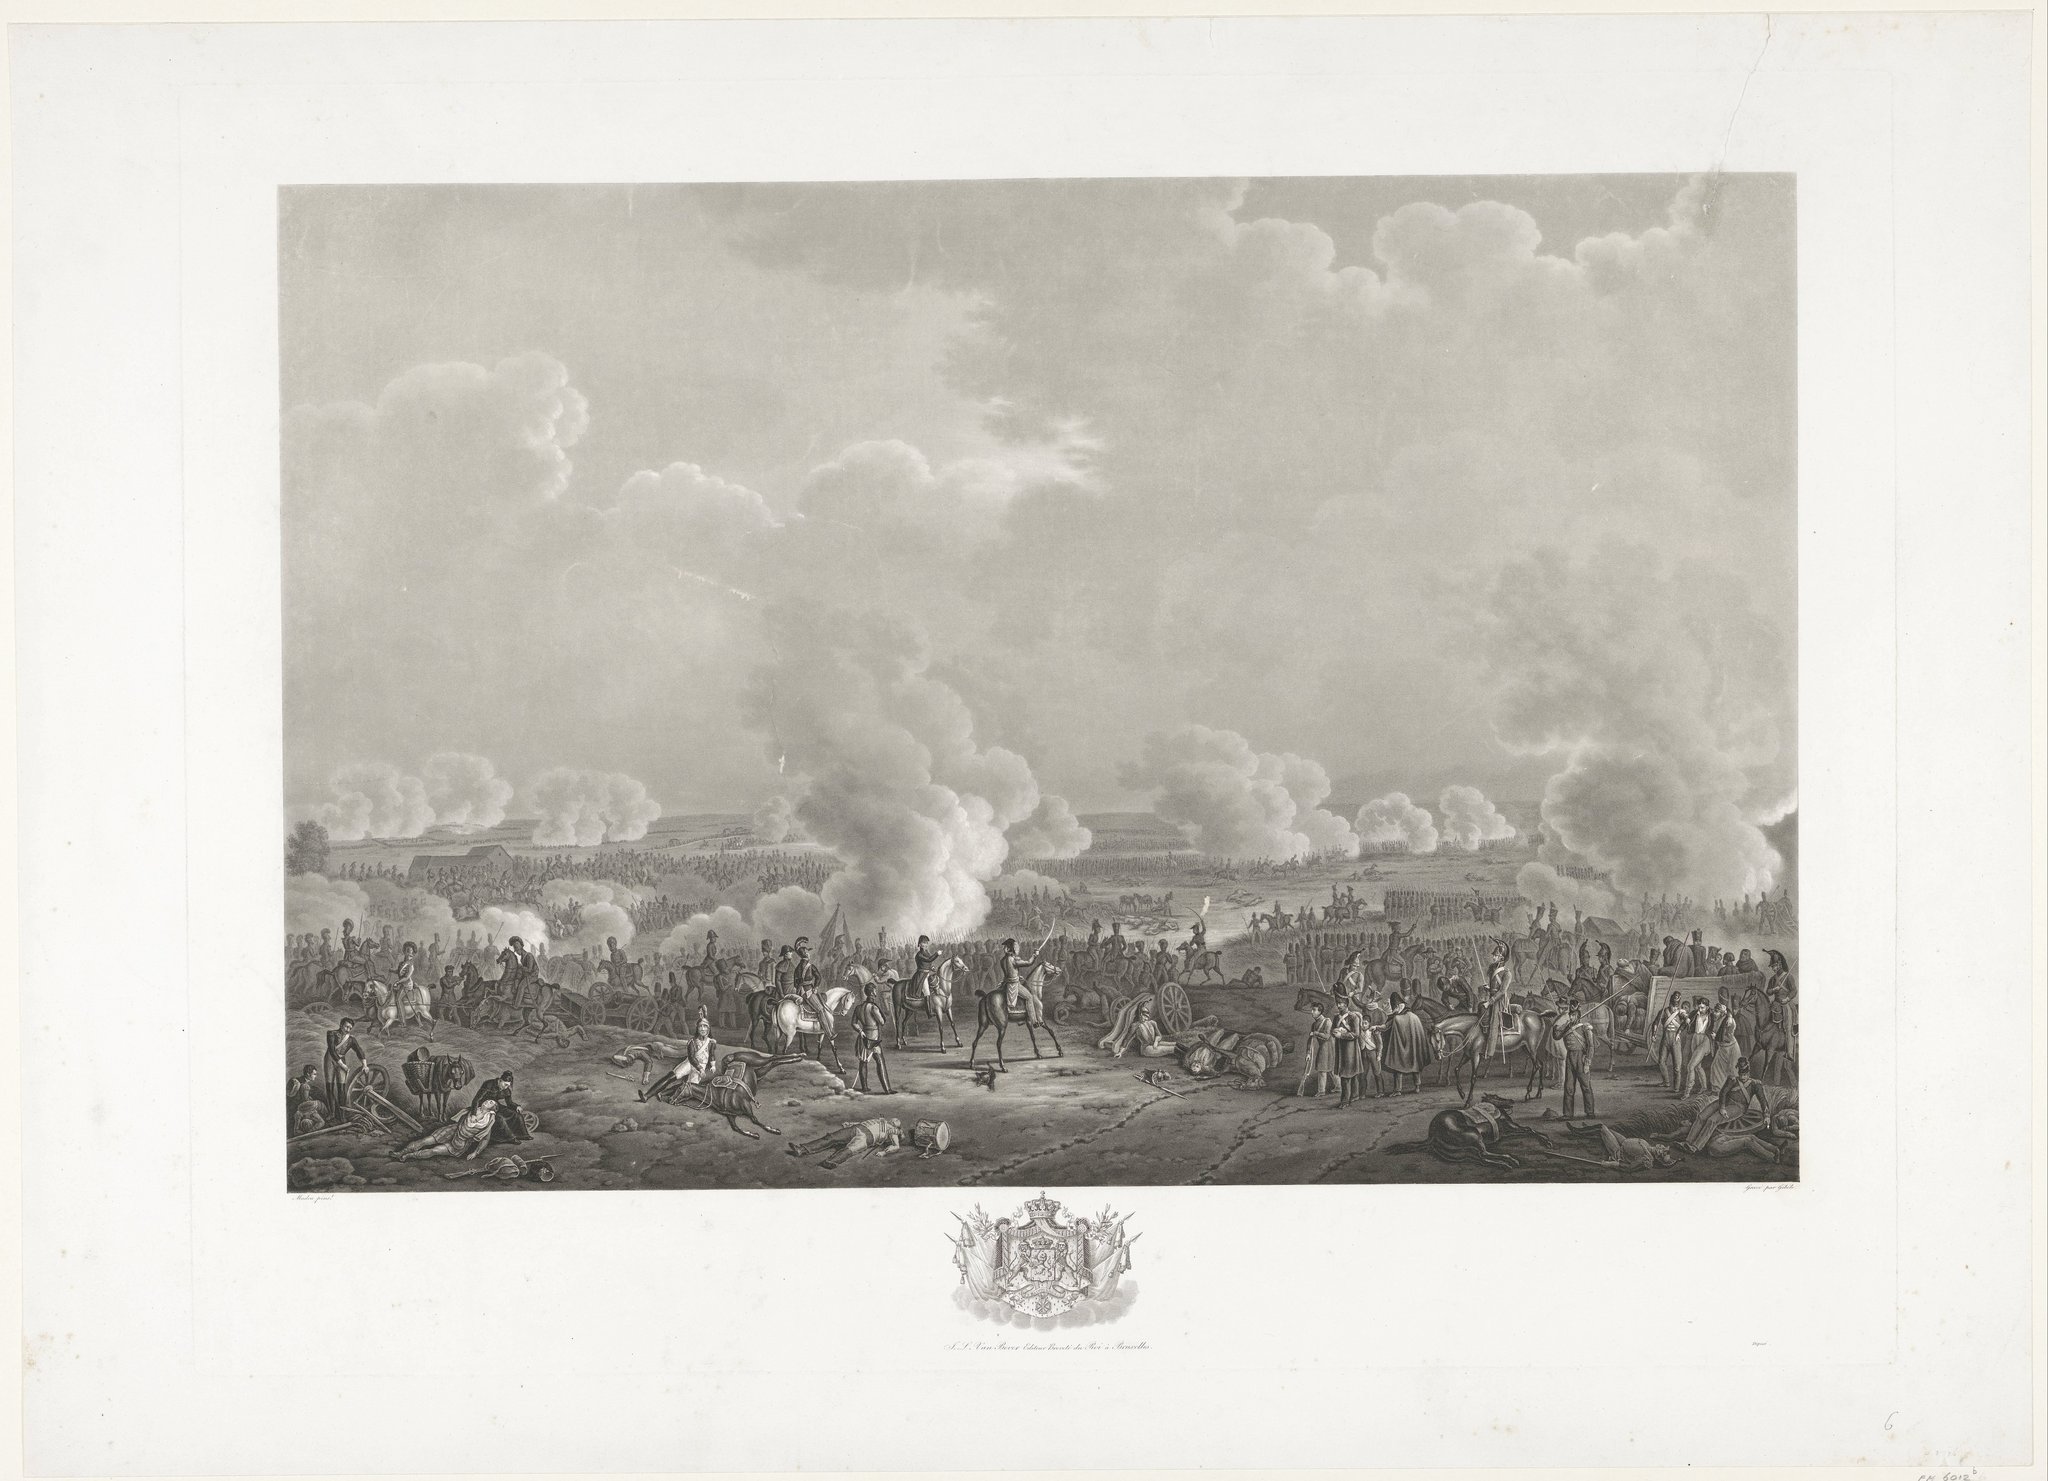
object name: print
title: Twaalf platen van de aankomst en inhuldiging van Willem I in Brussel en de slagen bij Quatre-Bras en Waterloo in 1815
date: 1825-1826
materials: paper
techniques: aquatint, etching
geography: brussels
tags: walmer castle, arthur wellesley of wellington, battle (+ land forces), waterloo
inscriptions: : ‘Déposé’, collector's mark: Lugt 12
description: De hertog van Wellington op het slagveld tijdens de slag bij Waterloo, 18 juni 1815. Centraal de prins te paard omgeven door zijn staf. Rechts een boerenwagen met doden en gewonden. Centraal onderaan het wapen van koning Willem I. Behoort bij een serie platen over de inhuldiging van Willem I in Brussel. Zie ook de pendant.